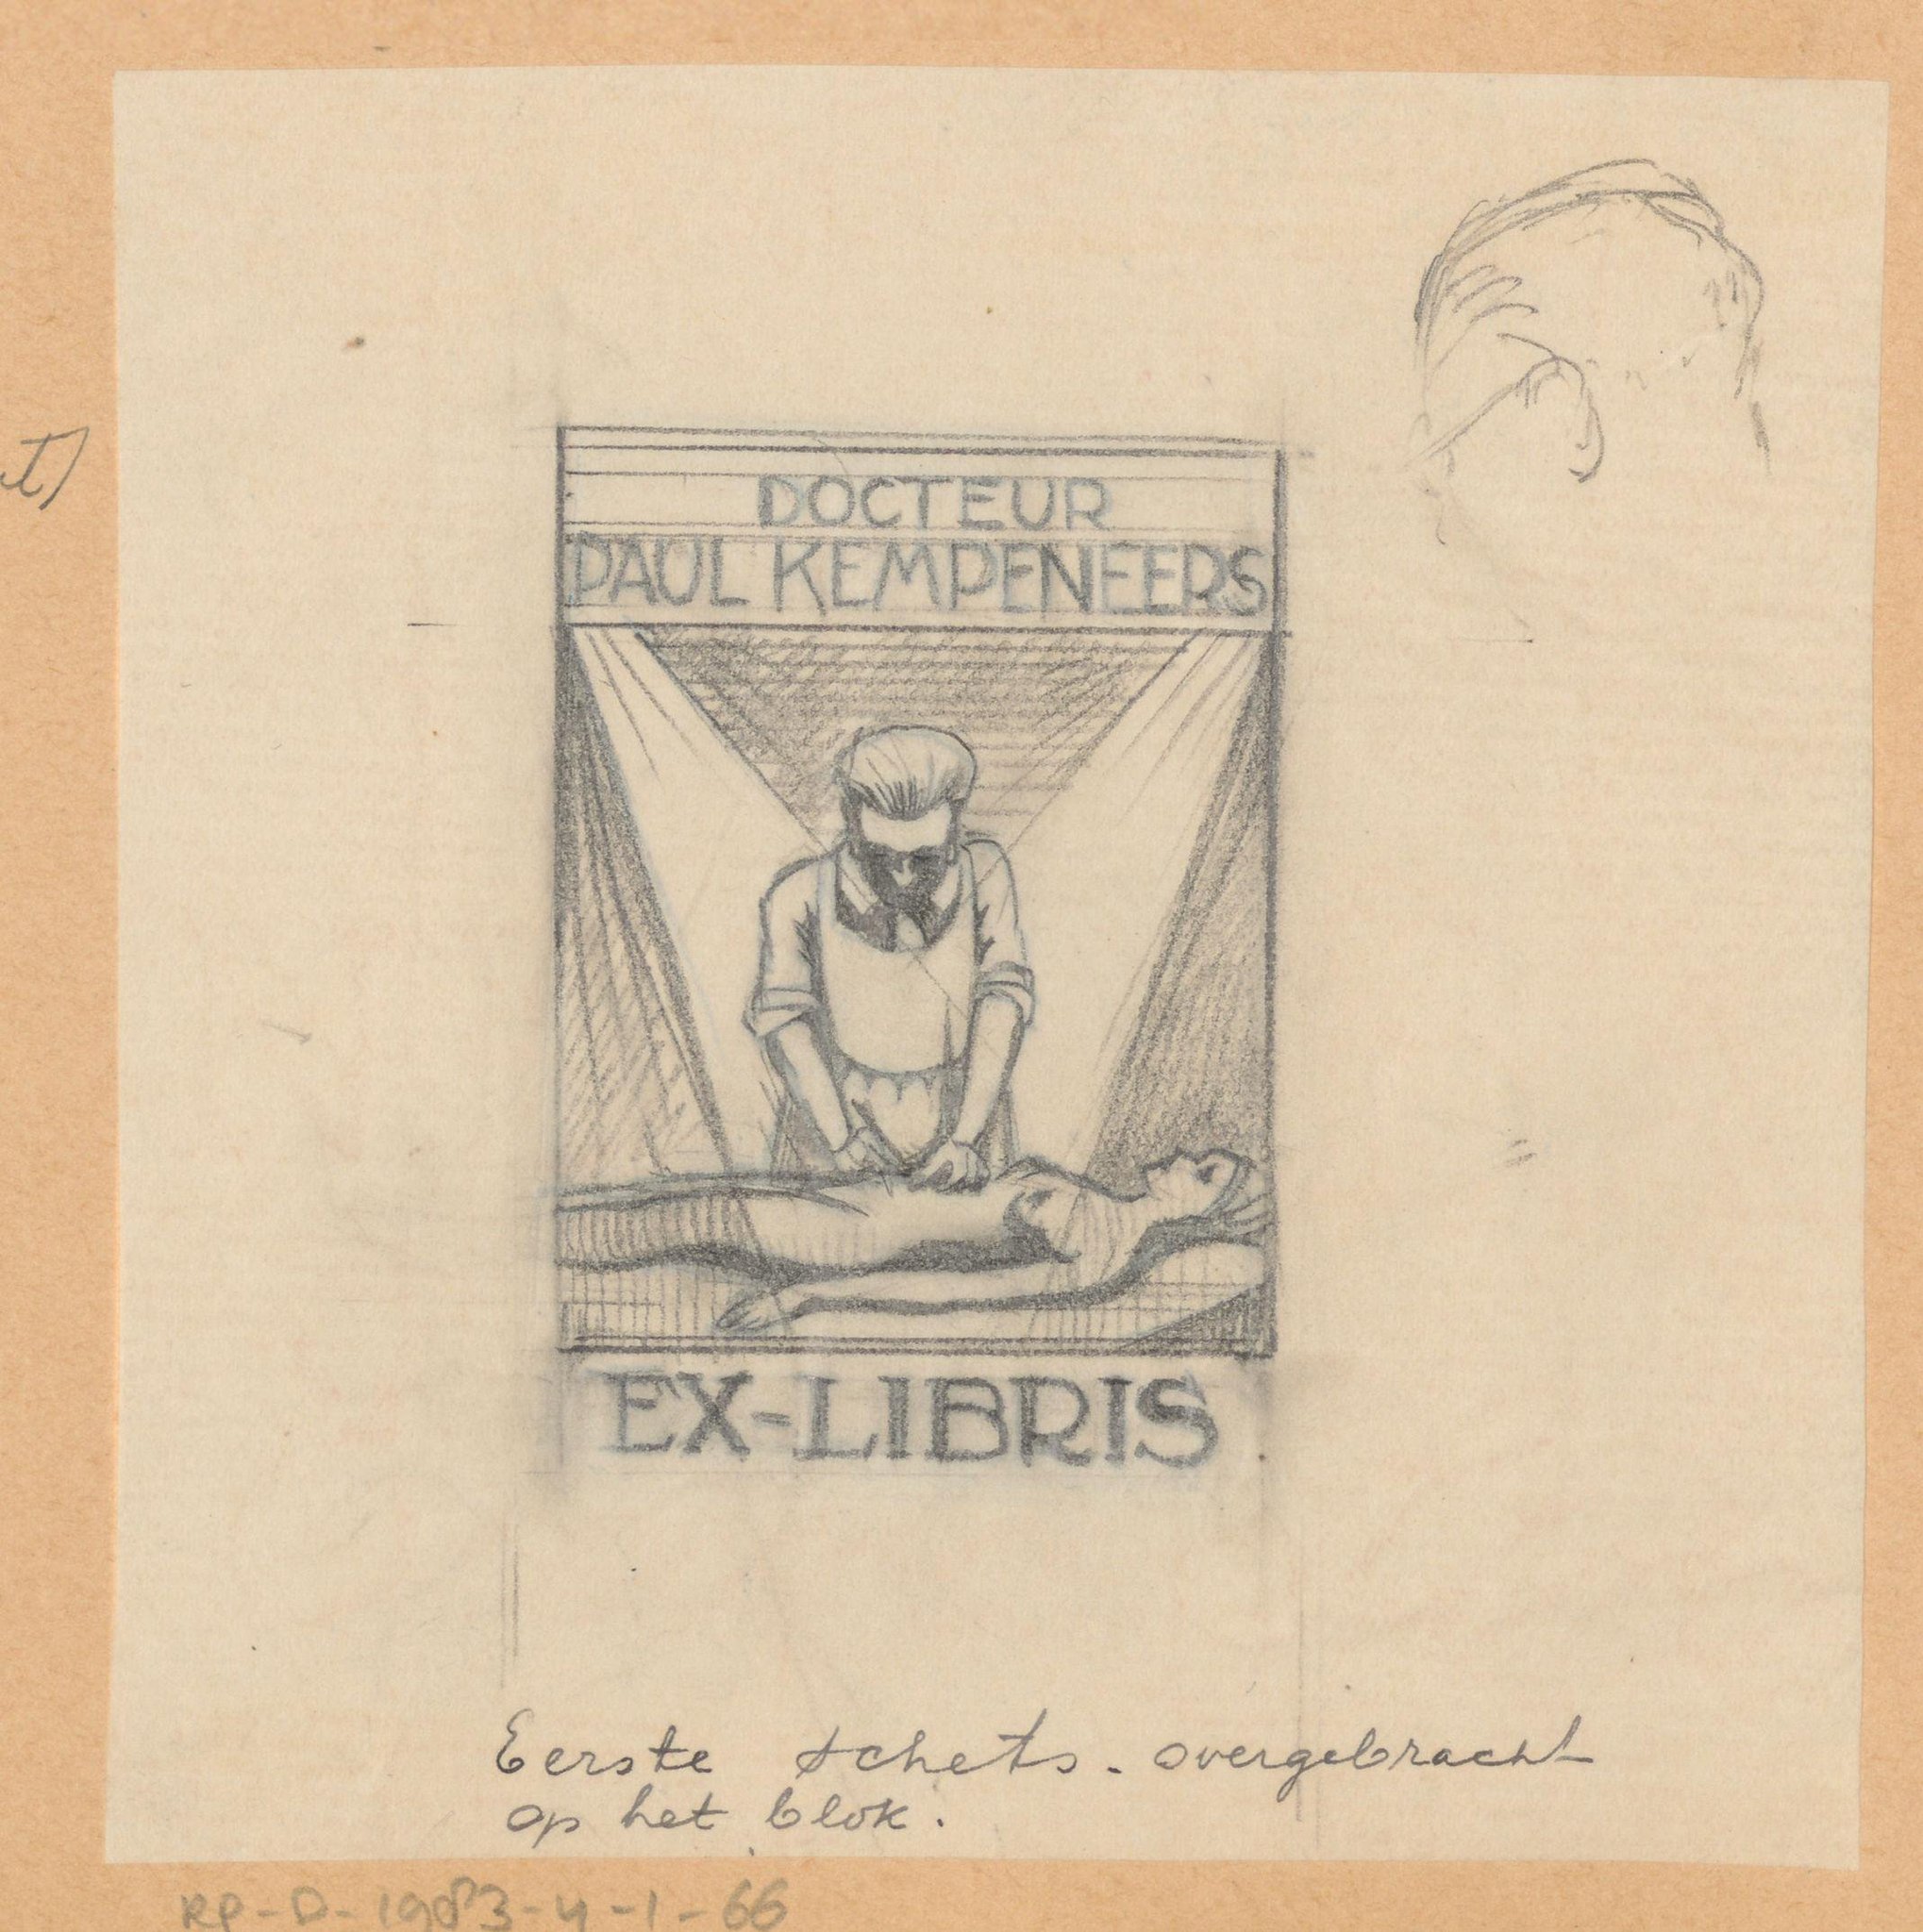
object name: design drawing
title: Ontwerptekening voor ex libris van Paul Kempeneers met schets van een hoofd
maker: otto verhagen (i)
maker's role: draughtsman, print maker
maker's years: 1885-1951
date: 1932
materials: paper, pencil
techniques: drawing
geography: netherlands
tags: paul kempeneers, physician, doctor, operation, surgery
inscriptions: inscription: ‘Eerste schets, overgebracht/ op het blok’